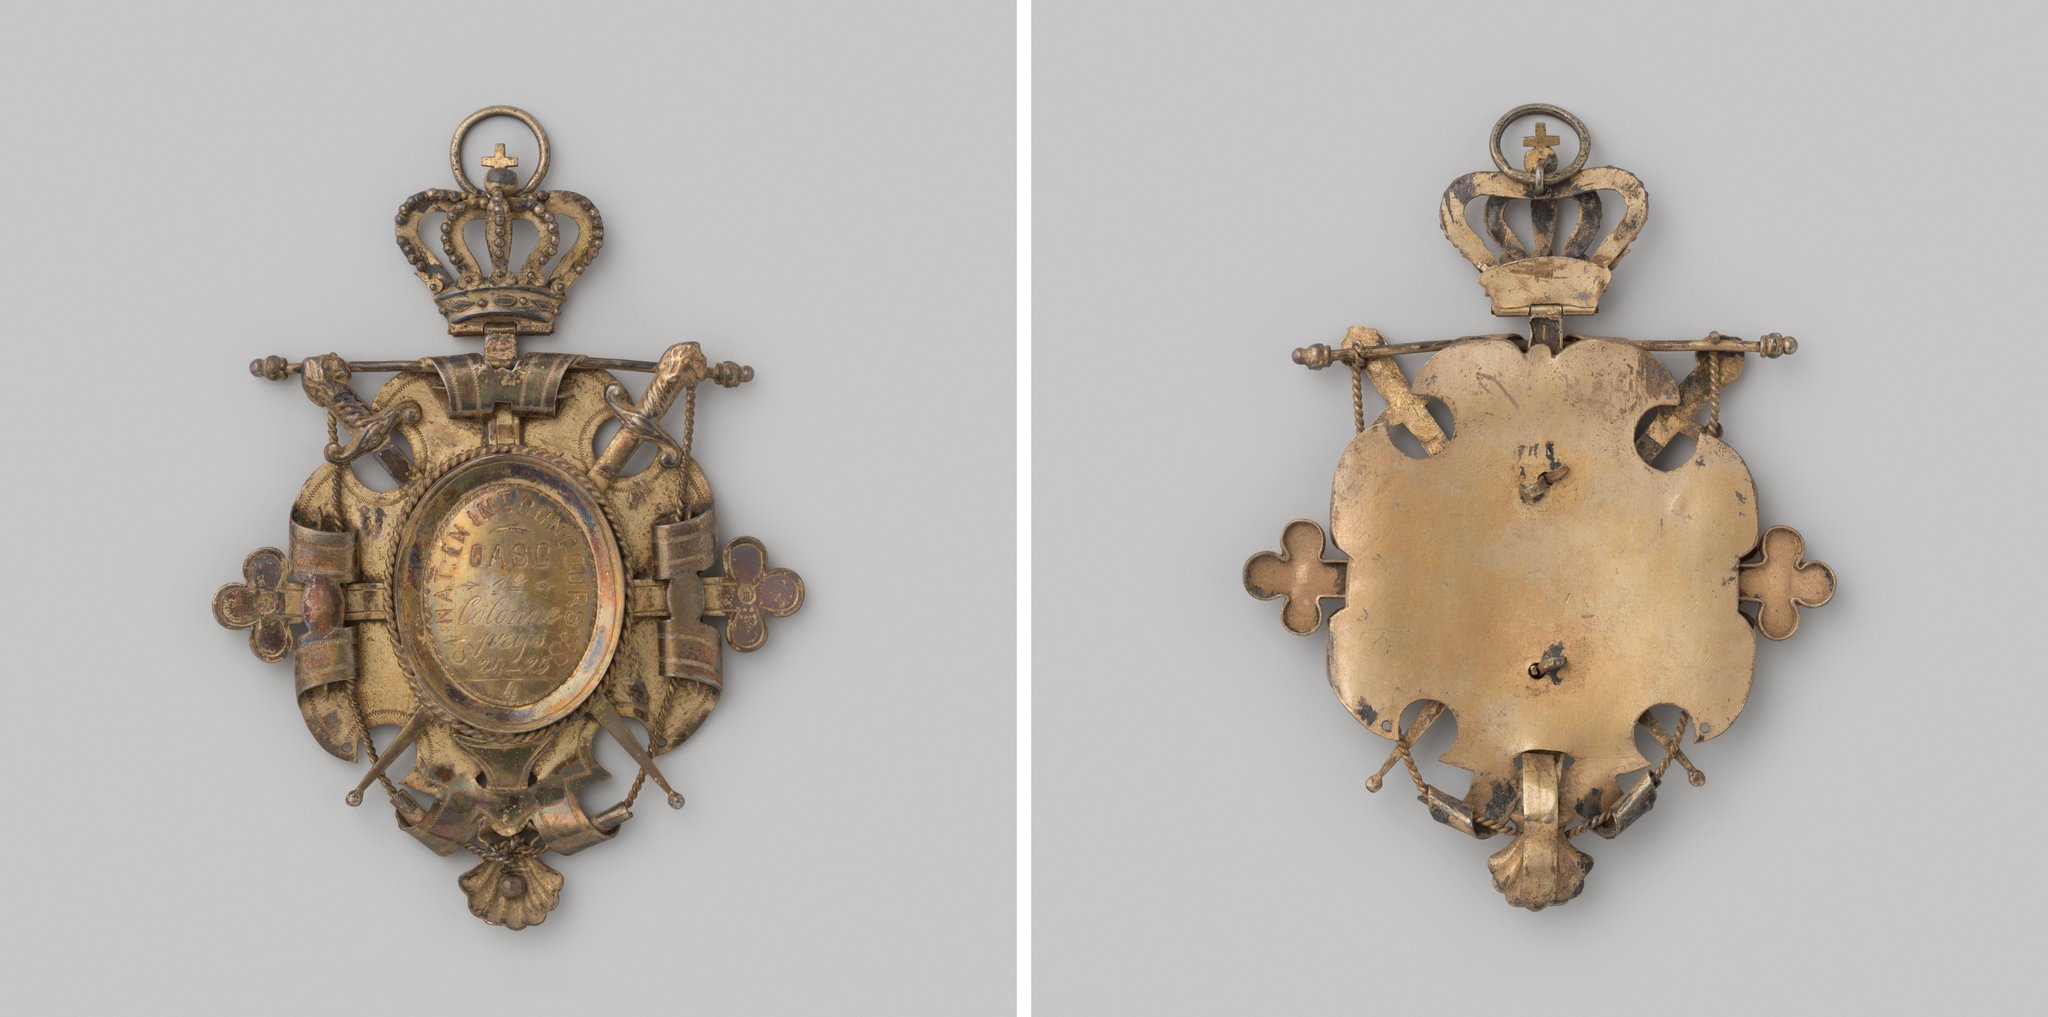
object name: medal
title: Prijspenning nationaal en internationaal concours van de onderlinge Amsterdamse schermcursus, behaald door de vereniging van onderofficieren van de schutterij te Amsterdam, eerste Colonneprijs voor schermen op de degen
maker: Anonymous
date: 1885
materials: silver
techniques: gilding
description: Verguld zilveren penning gedekt door een koningskroon met oog en ring.